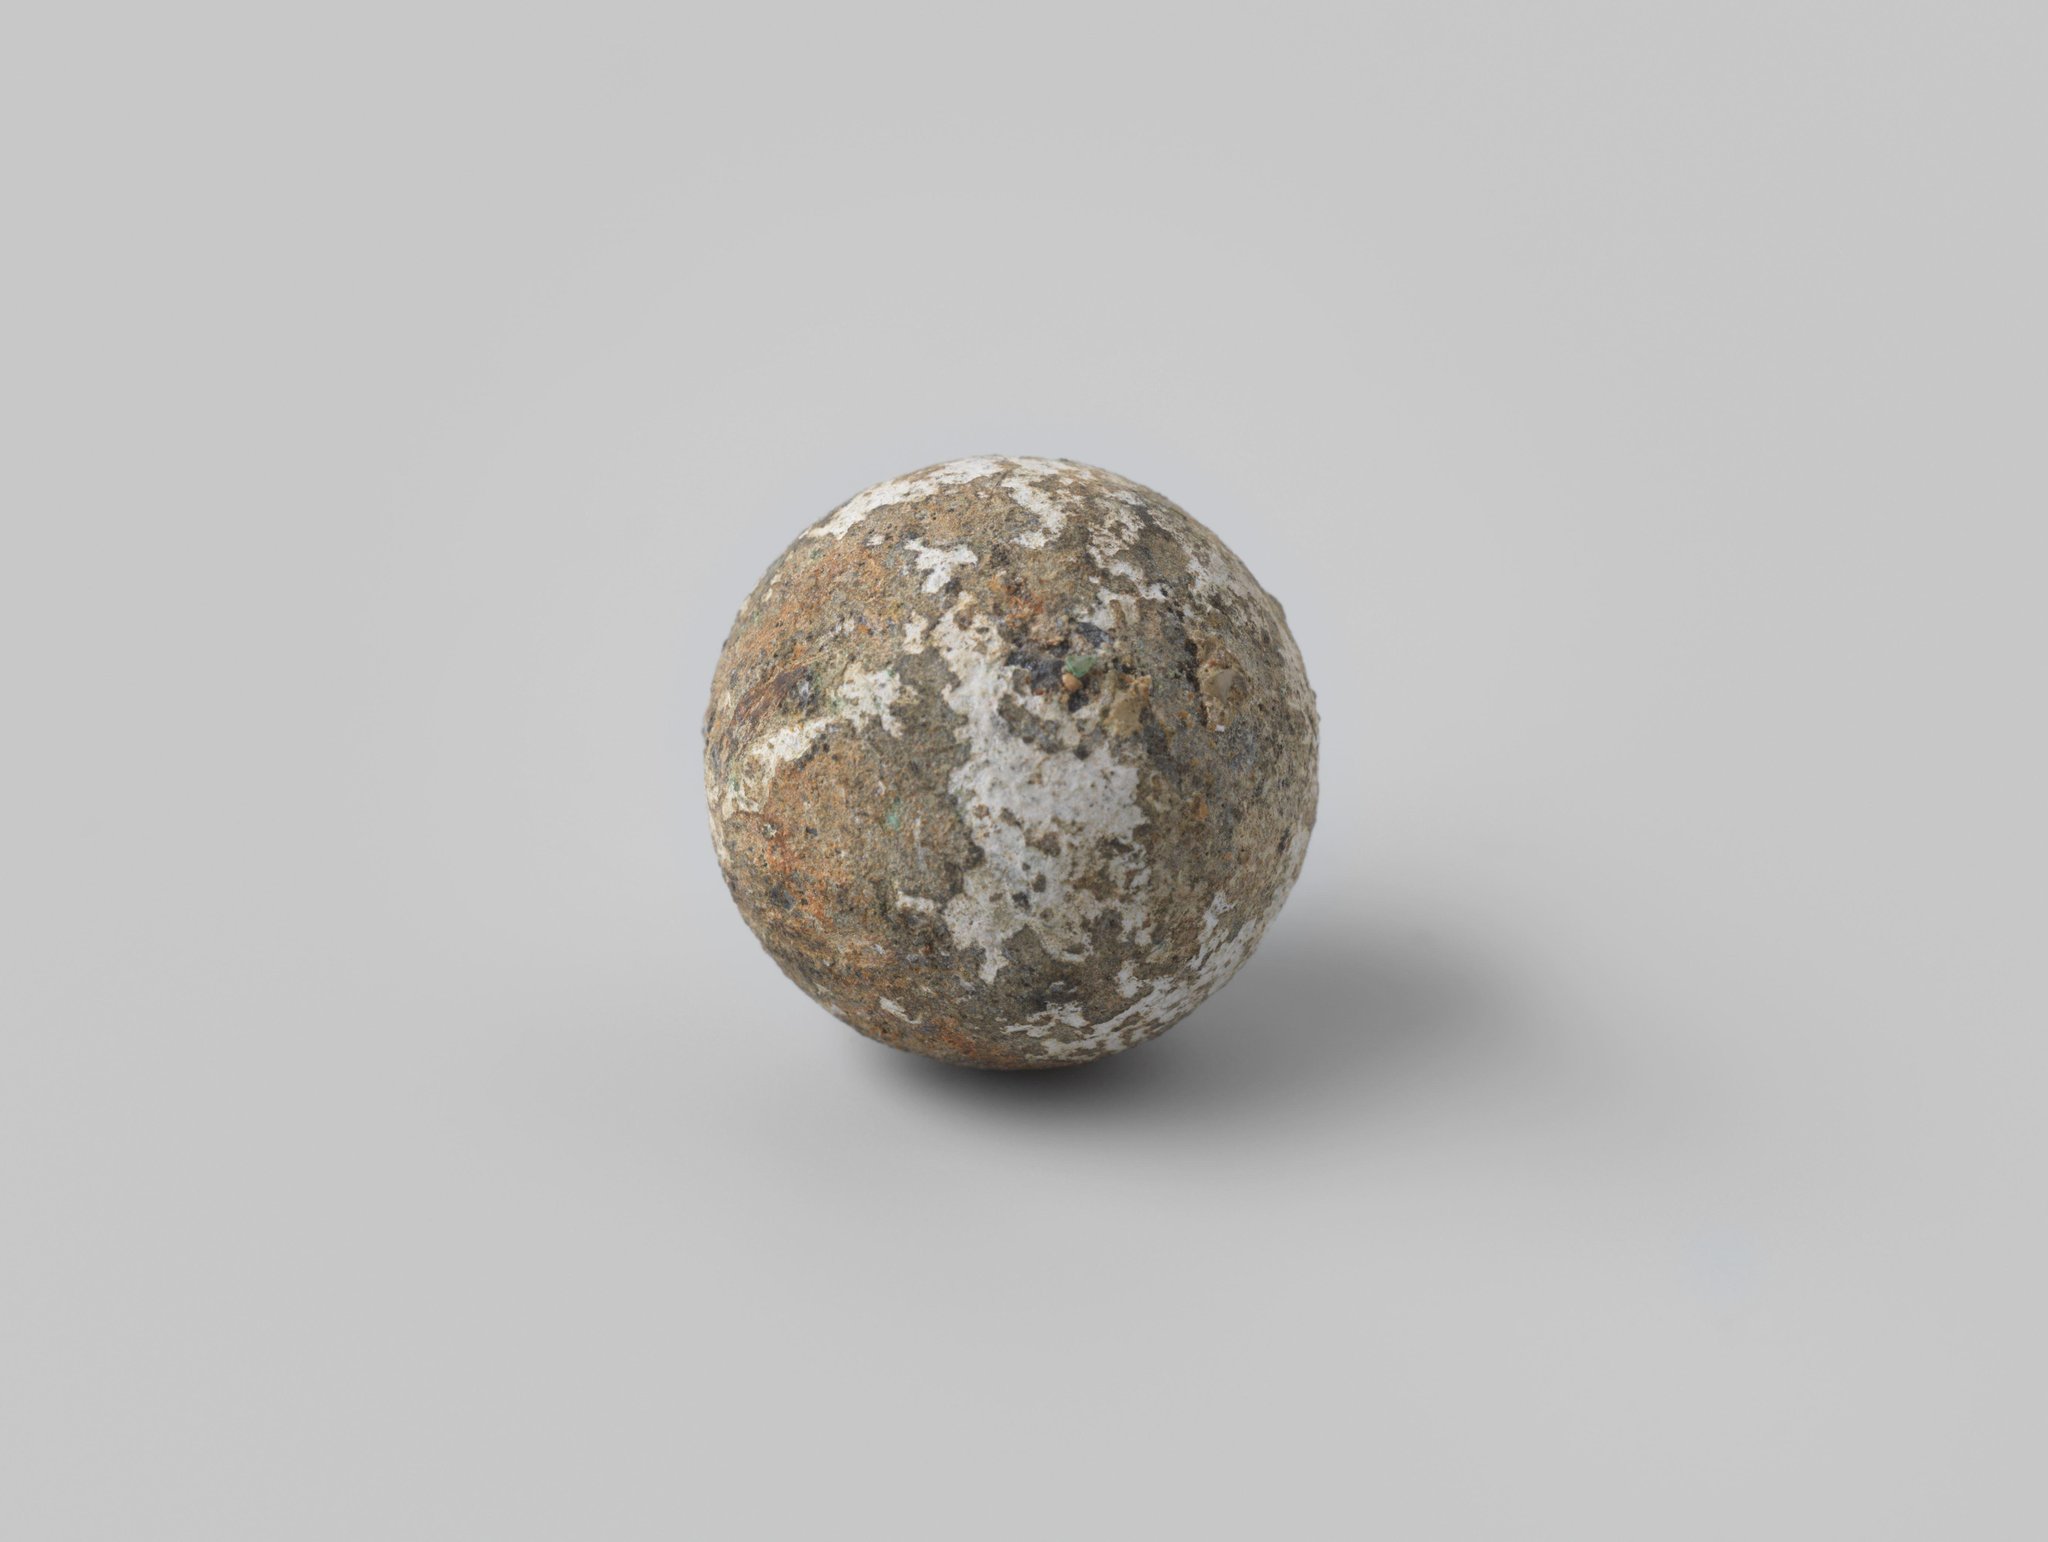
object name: musketkogel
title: Musketkogel uit het wrak van de Oost-Indiëvaarder Hollandia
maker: Anonymous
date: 1700-1743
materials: lead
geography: netherlands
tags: verenigde oostindische compagnie, hollandia (schip), annet